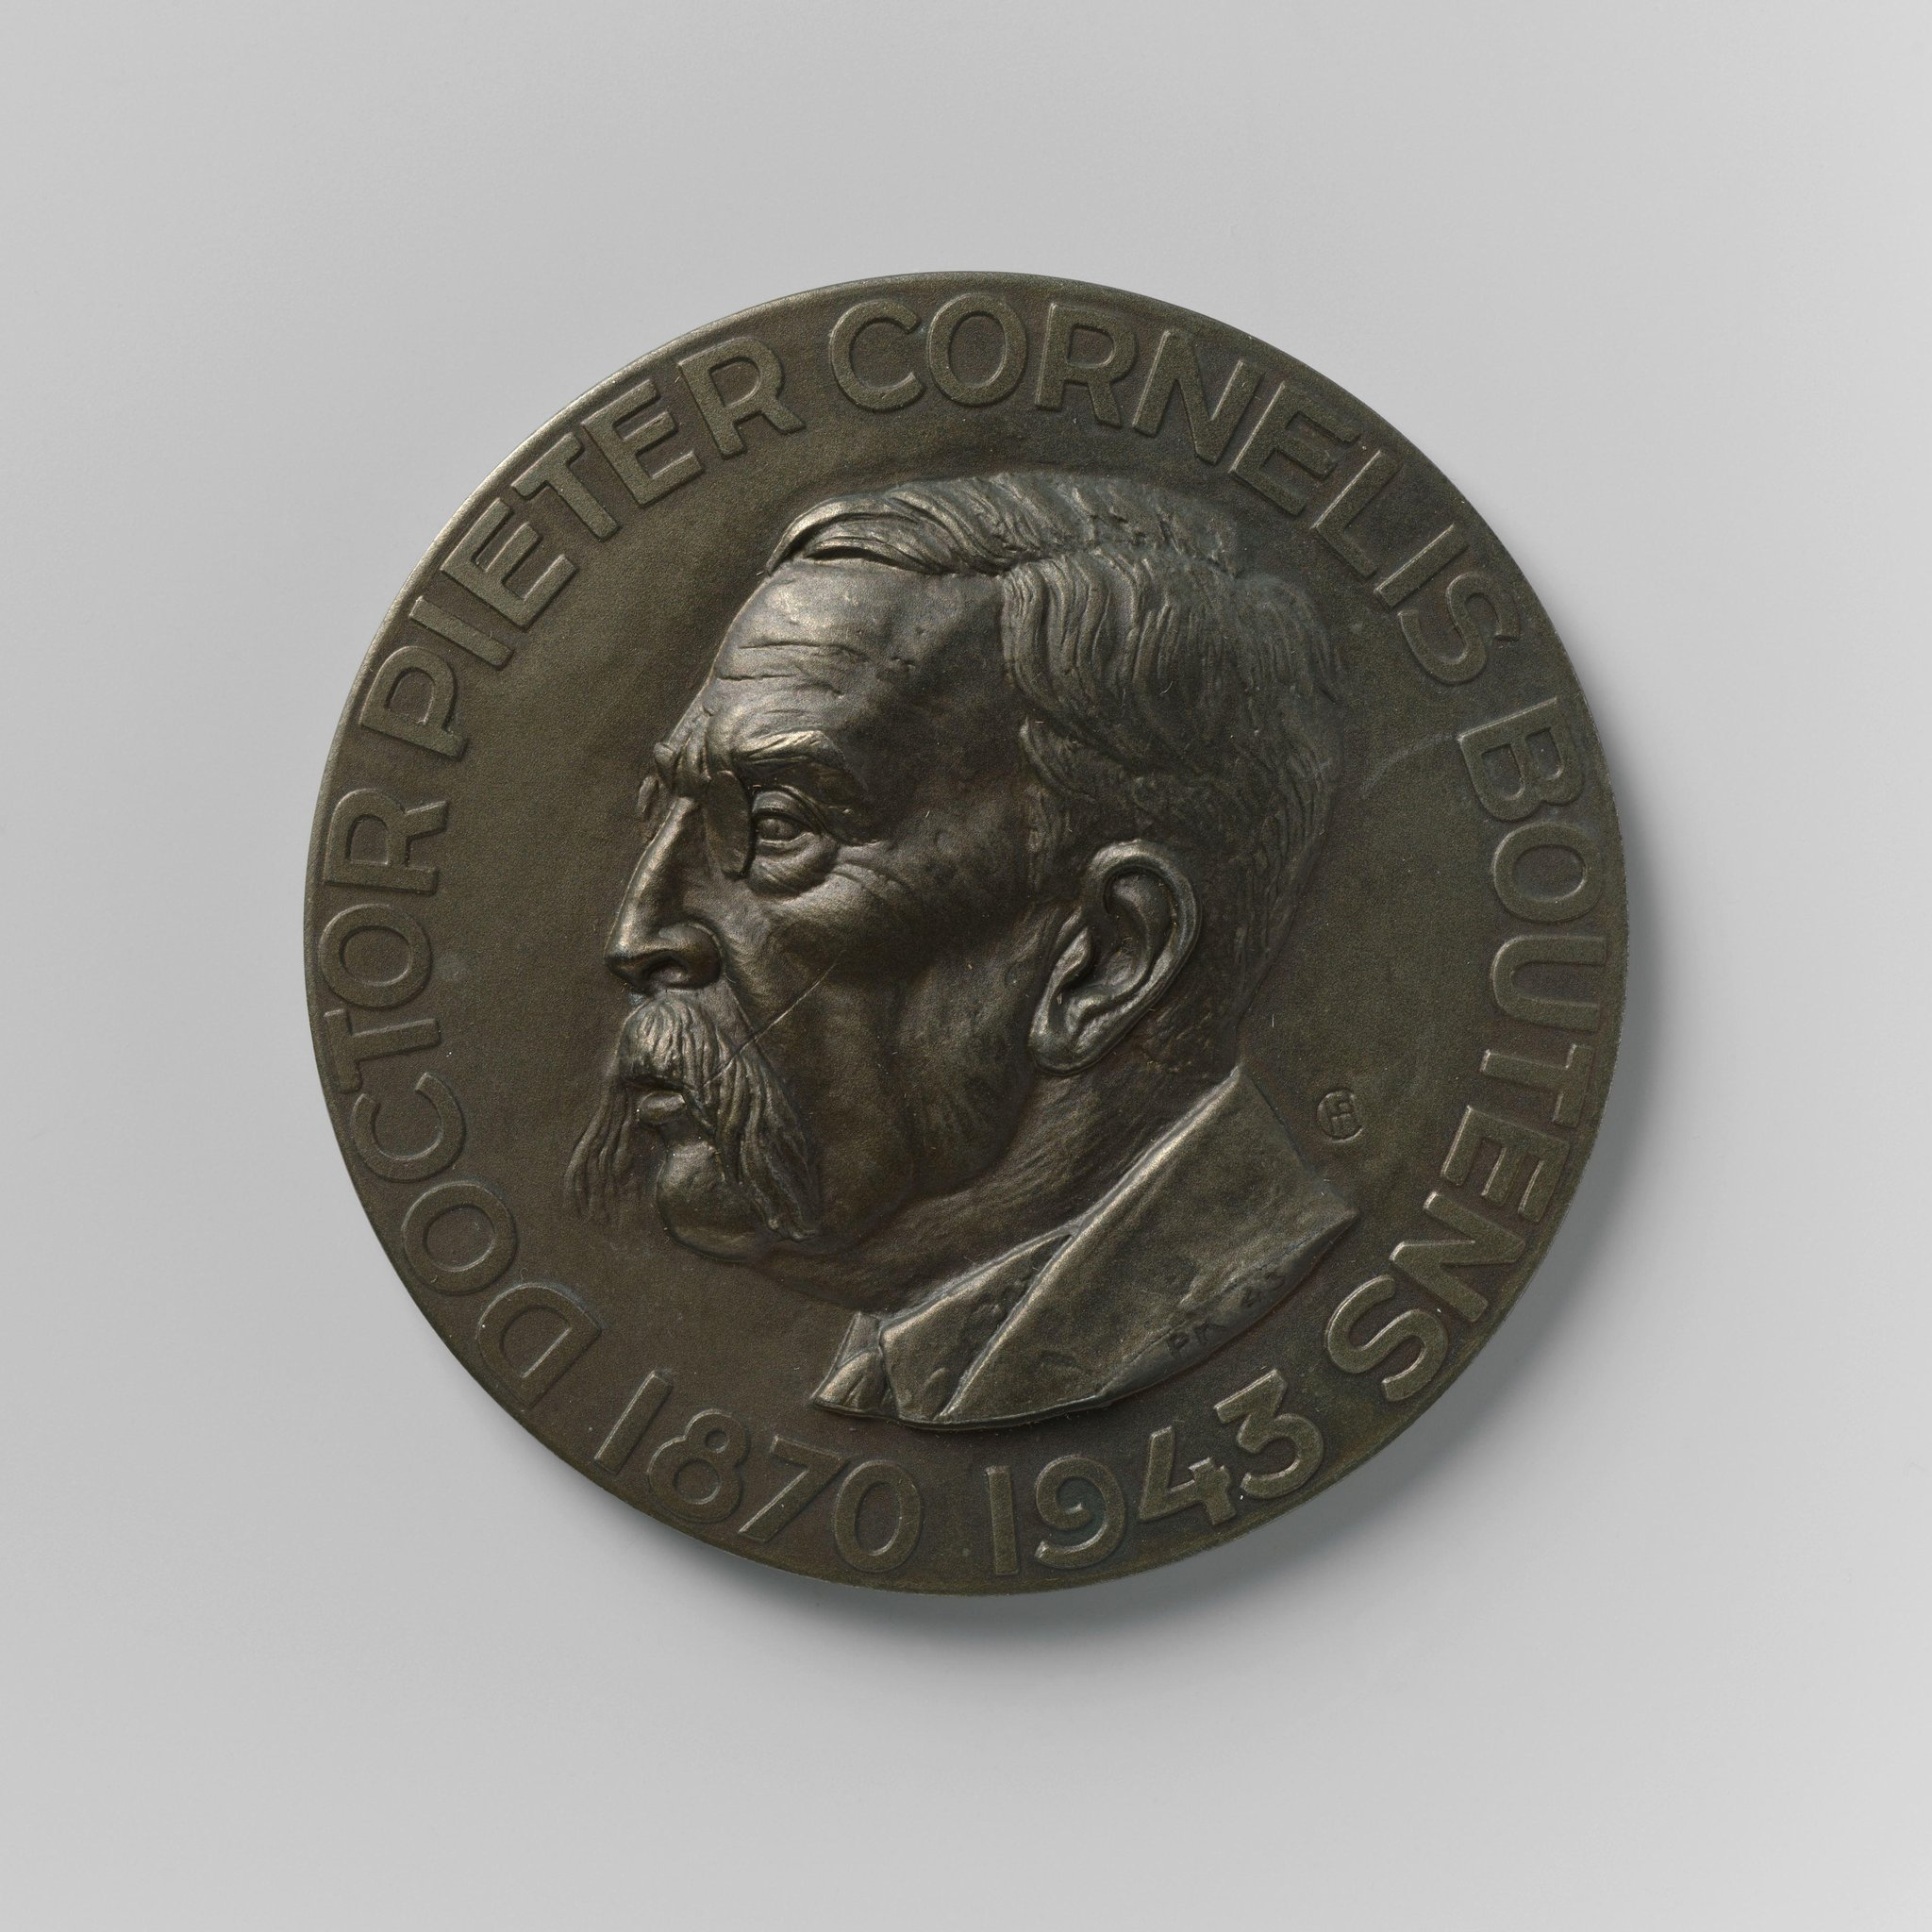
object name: history medal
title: Overlijden van doctor Pieter Cornelis Boutens (Vereniging voor Penningkunst 1943, jaarpenning)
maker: jacob jan van goor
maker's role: medailleur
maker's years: 1874-1956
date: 1943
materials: metal alloy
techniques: striking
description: Witmetalen penning, op de voorzijde het borstbeeld van Boutens naar links met omschrift, op de keerzijde een kleine phoenix met omschrift.